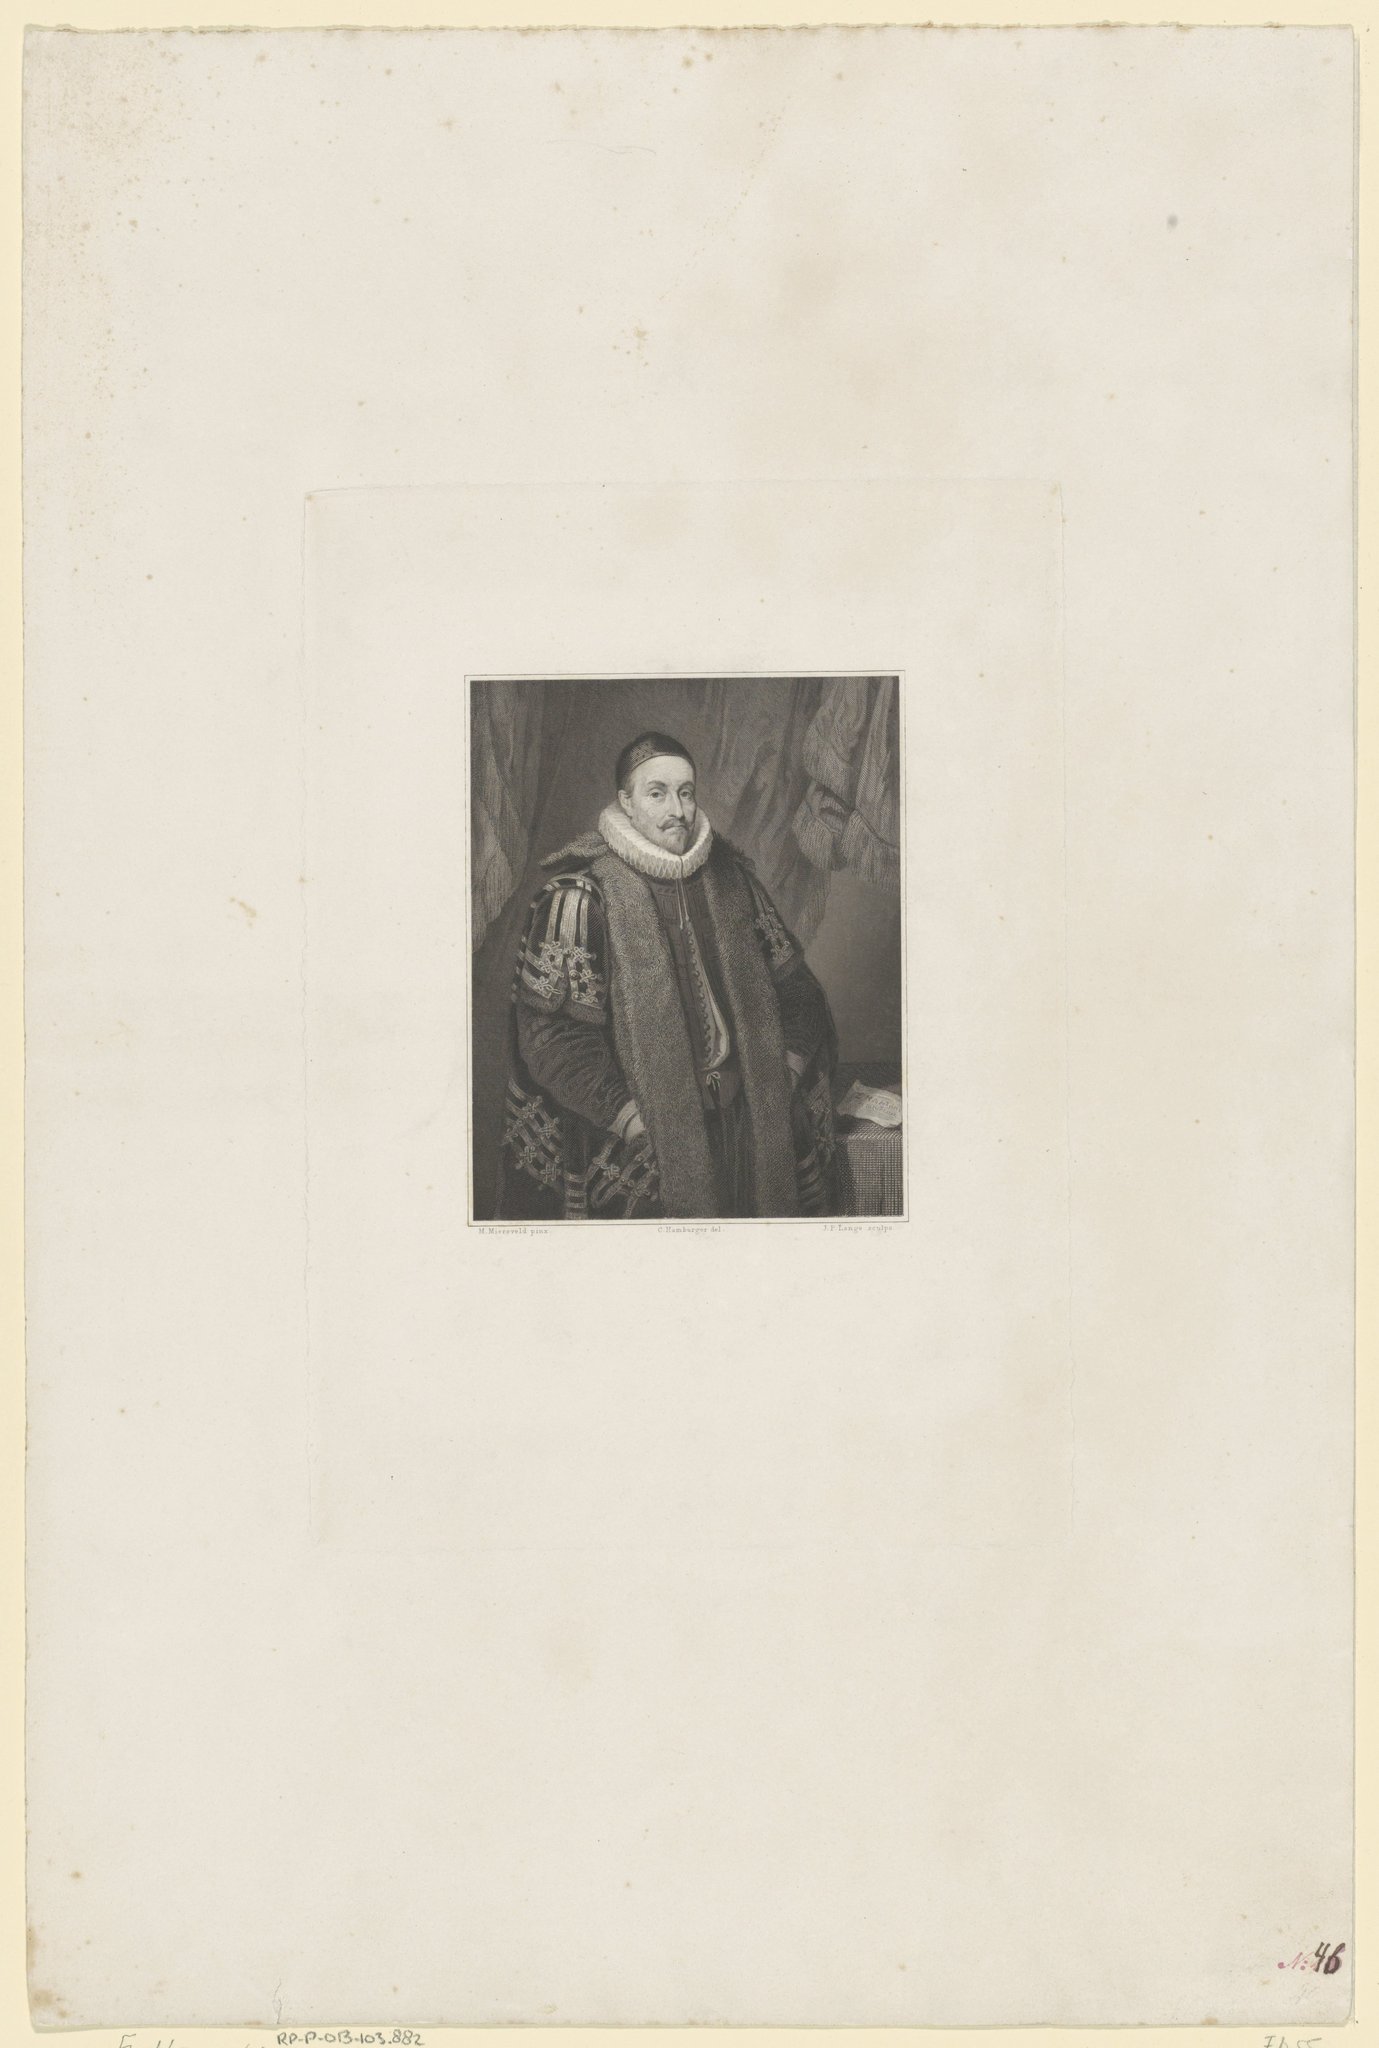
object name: print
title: Portret van Willem I, prins van Oranje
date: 1845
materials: paper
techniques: engraving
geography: amsterdam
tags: delft, william i (prince of orange)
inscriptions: collector's mark: Lugt 963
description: De hier vermelde titel verwijst naar de hoogst verkregen titel van de geportretteerde, niet per se naar de titel die de geportretteerde op deze voorstelling draagt.